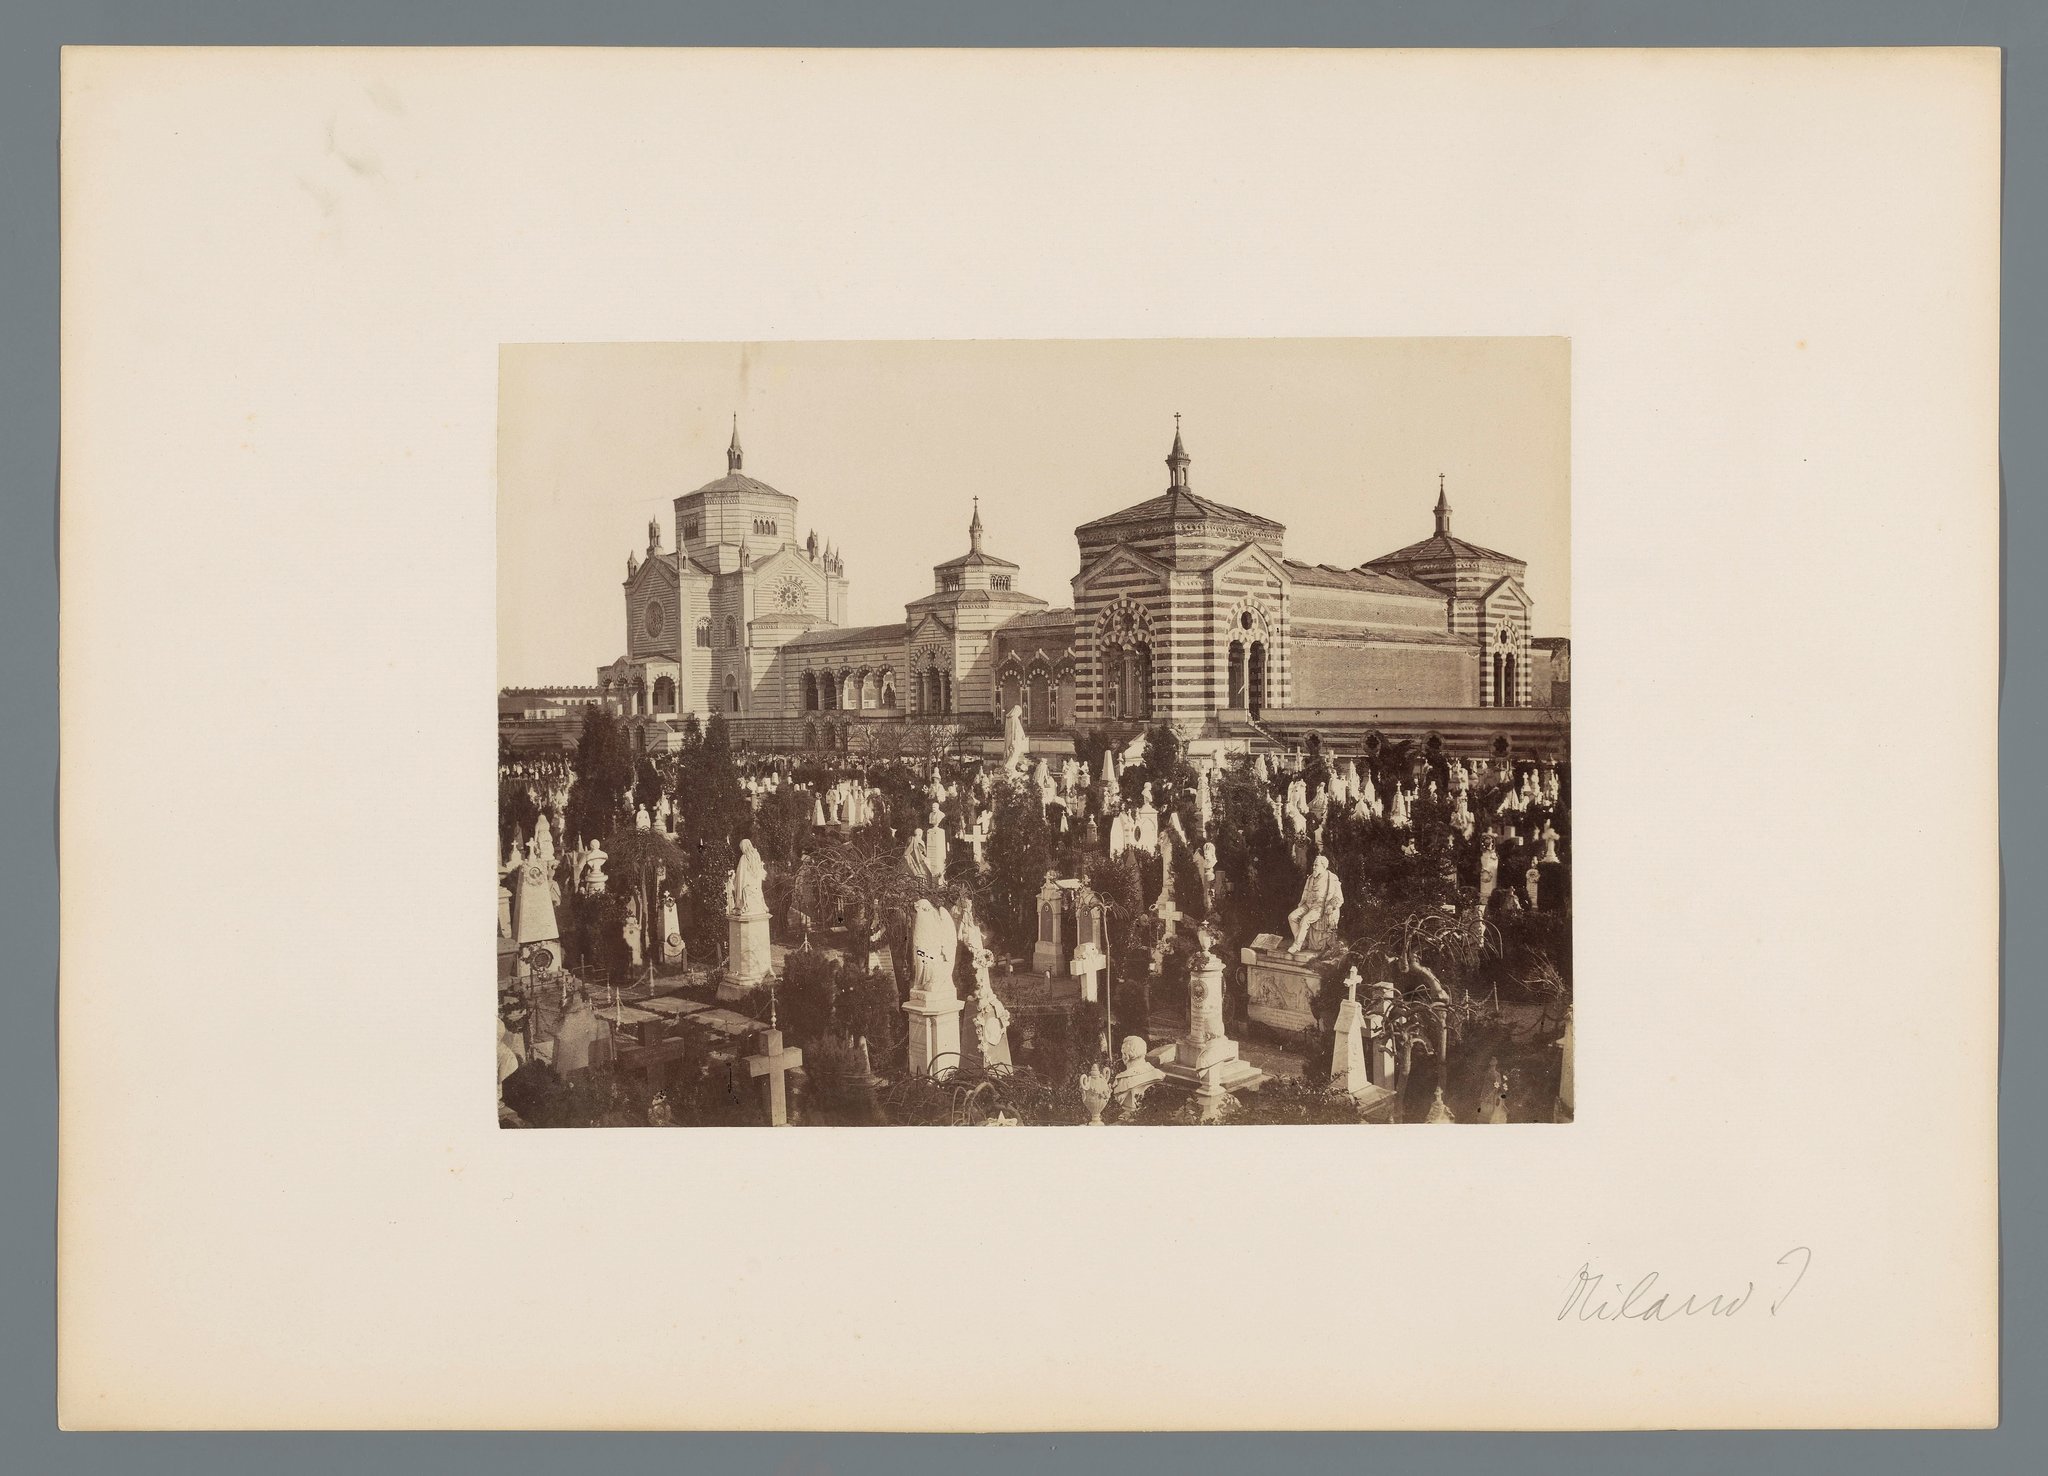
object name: stereograph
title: Gezicht op de Pont Louis-Philippe in Parijs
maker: Anonymous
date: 1850-1880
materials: cardboard, photographic support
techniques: albumen print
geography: paris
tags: bridge in city across river, canal, etc.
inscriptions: inscription: ‘Parijs, Pont Louis Philippe No. 9. f.m.’